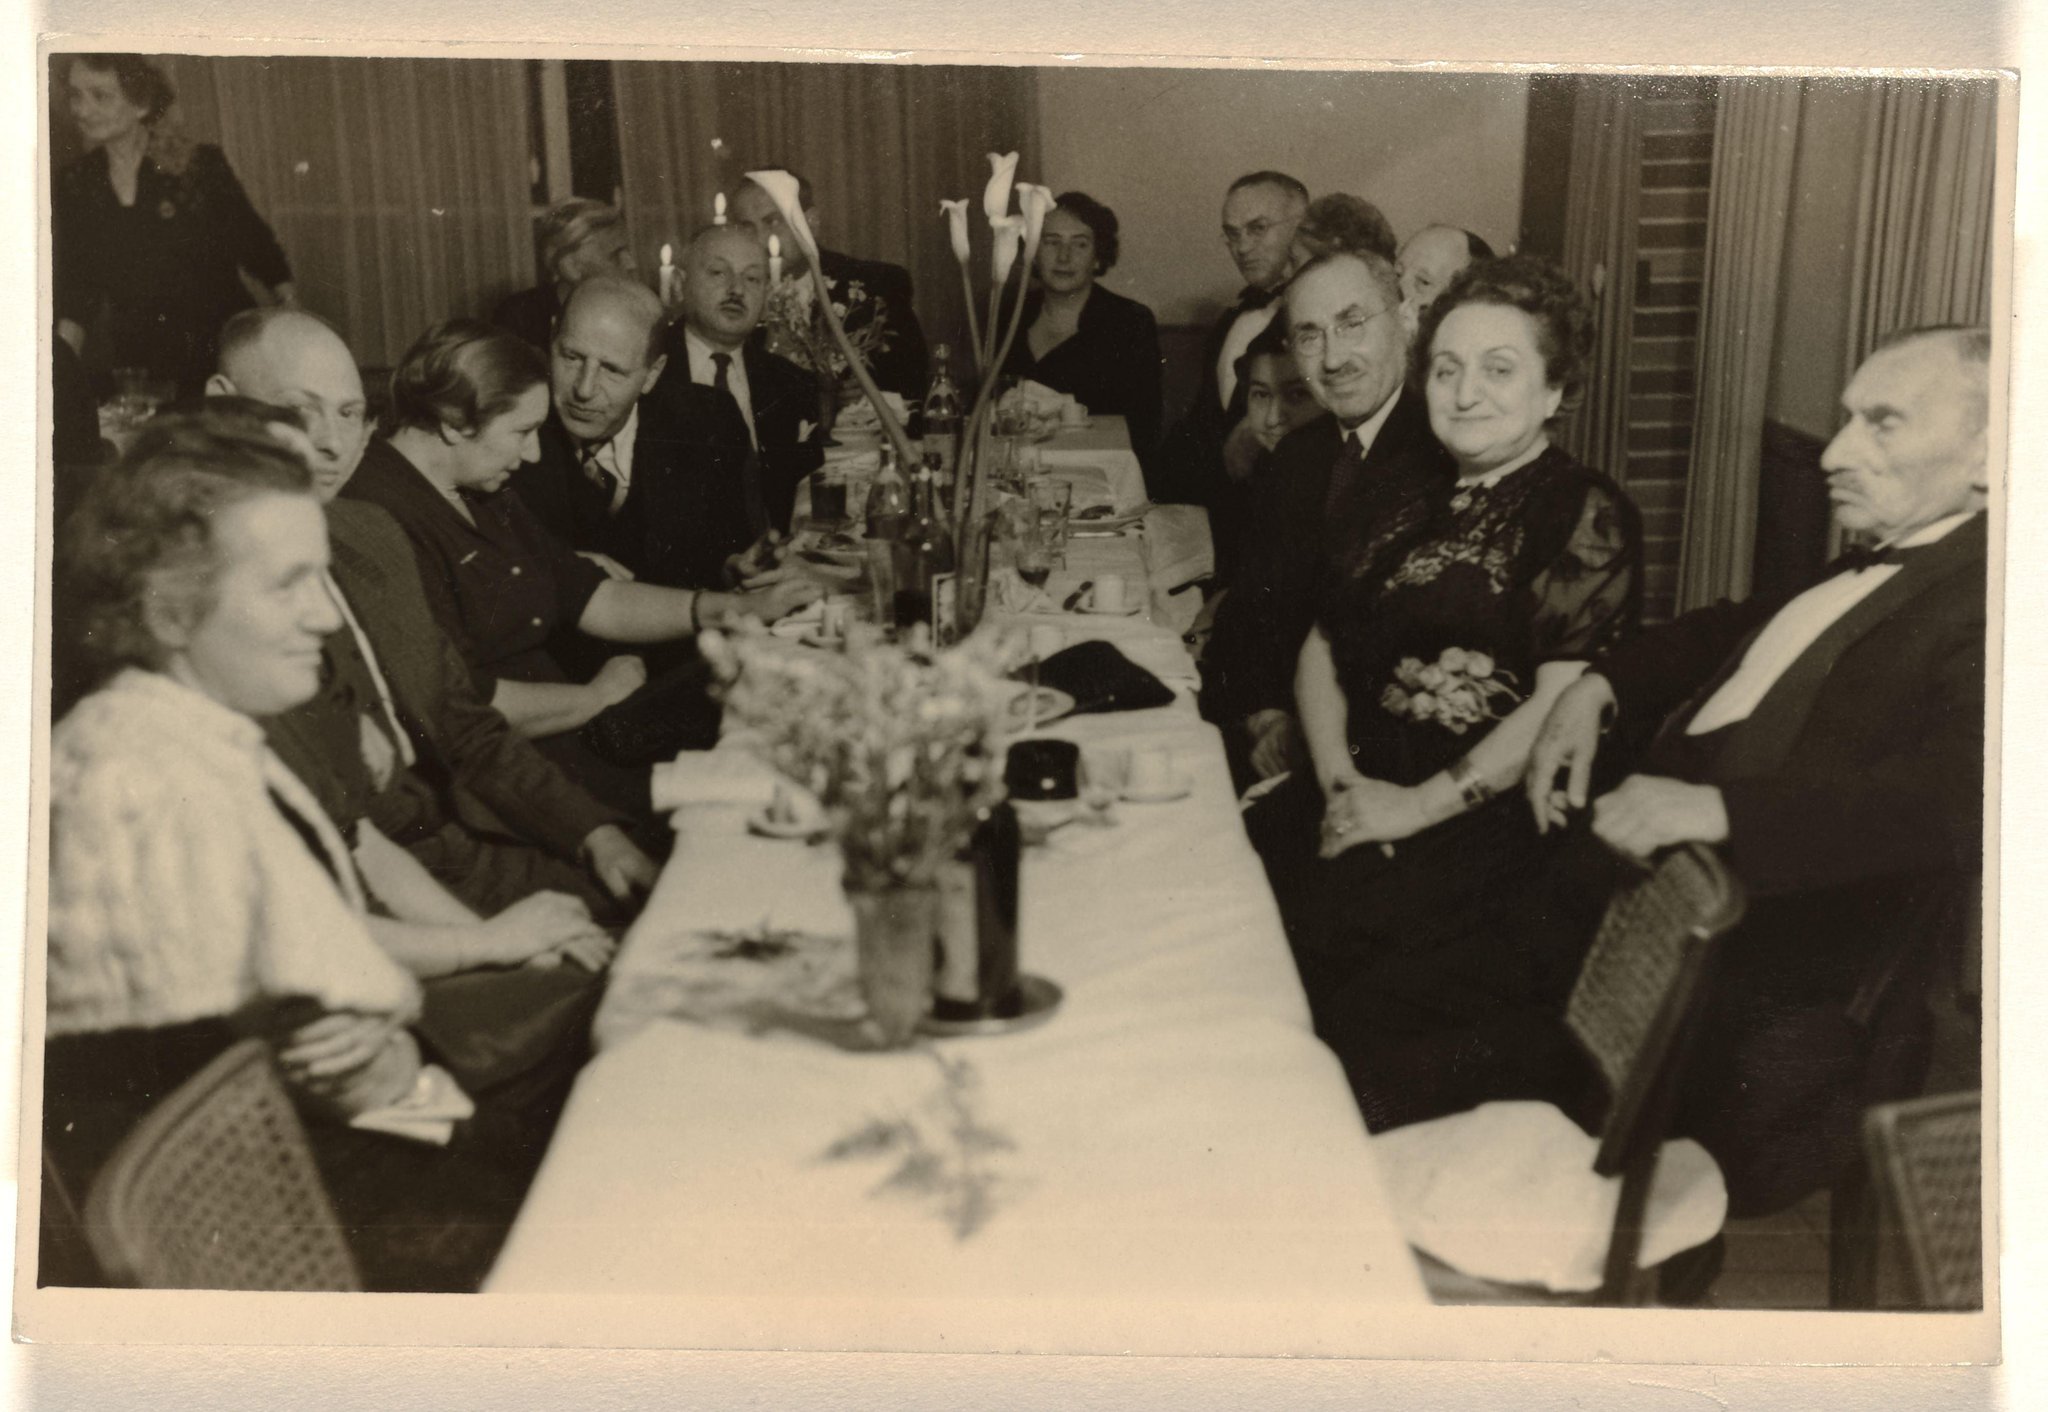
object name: photograph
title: Rij onbekende mensen in feestelijke kleding gezeten aan een tafel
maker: Anonymous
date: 1949-1955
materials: photographic support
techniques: gelatin silver print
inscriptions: inscription: ‘Grosse Feier bei Frank 914/25 1950’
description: Rij onbekende mensen in feestelijke kleding gezeten aan een tafel. Foto gerelateerd aan de Wachenheimer familie.